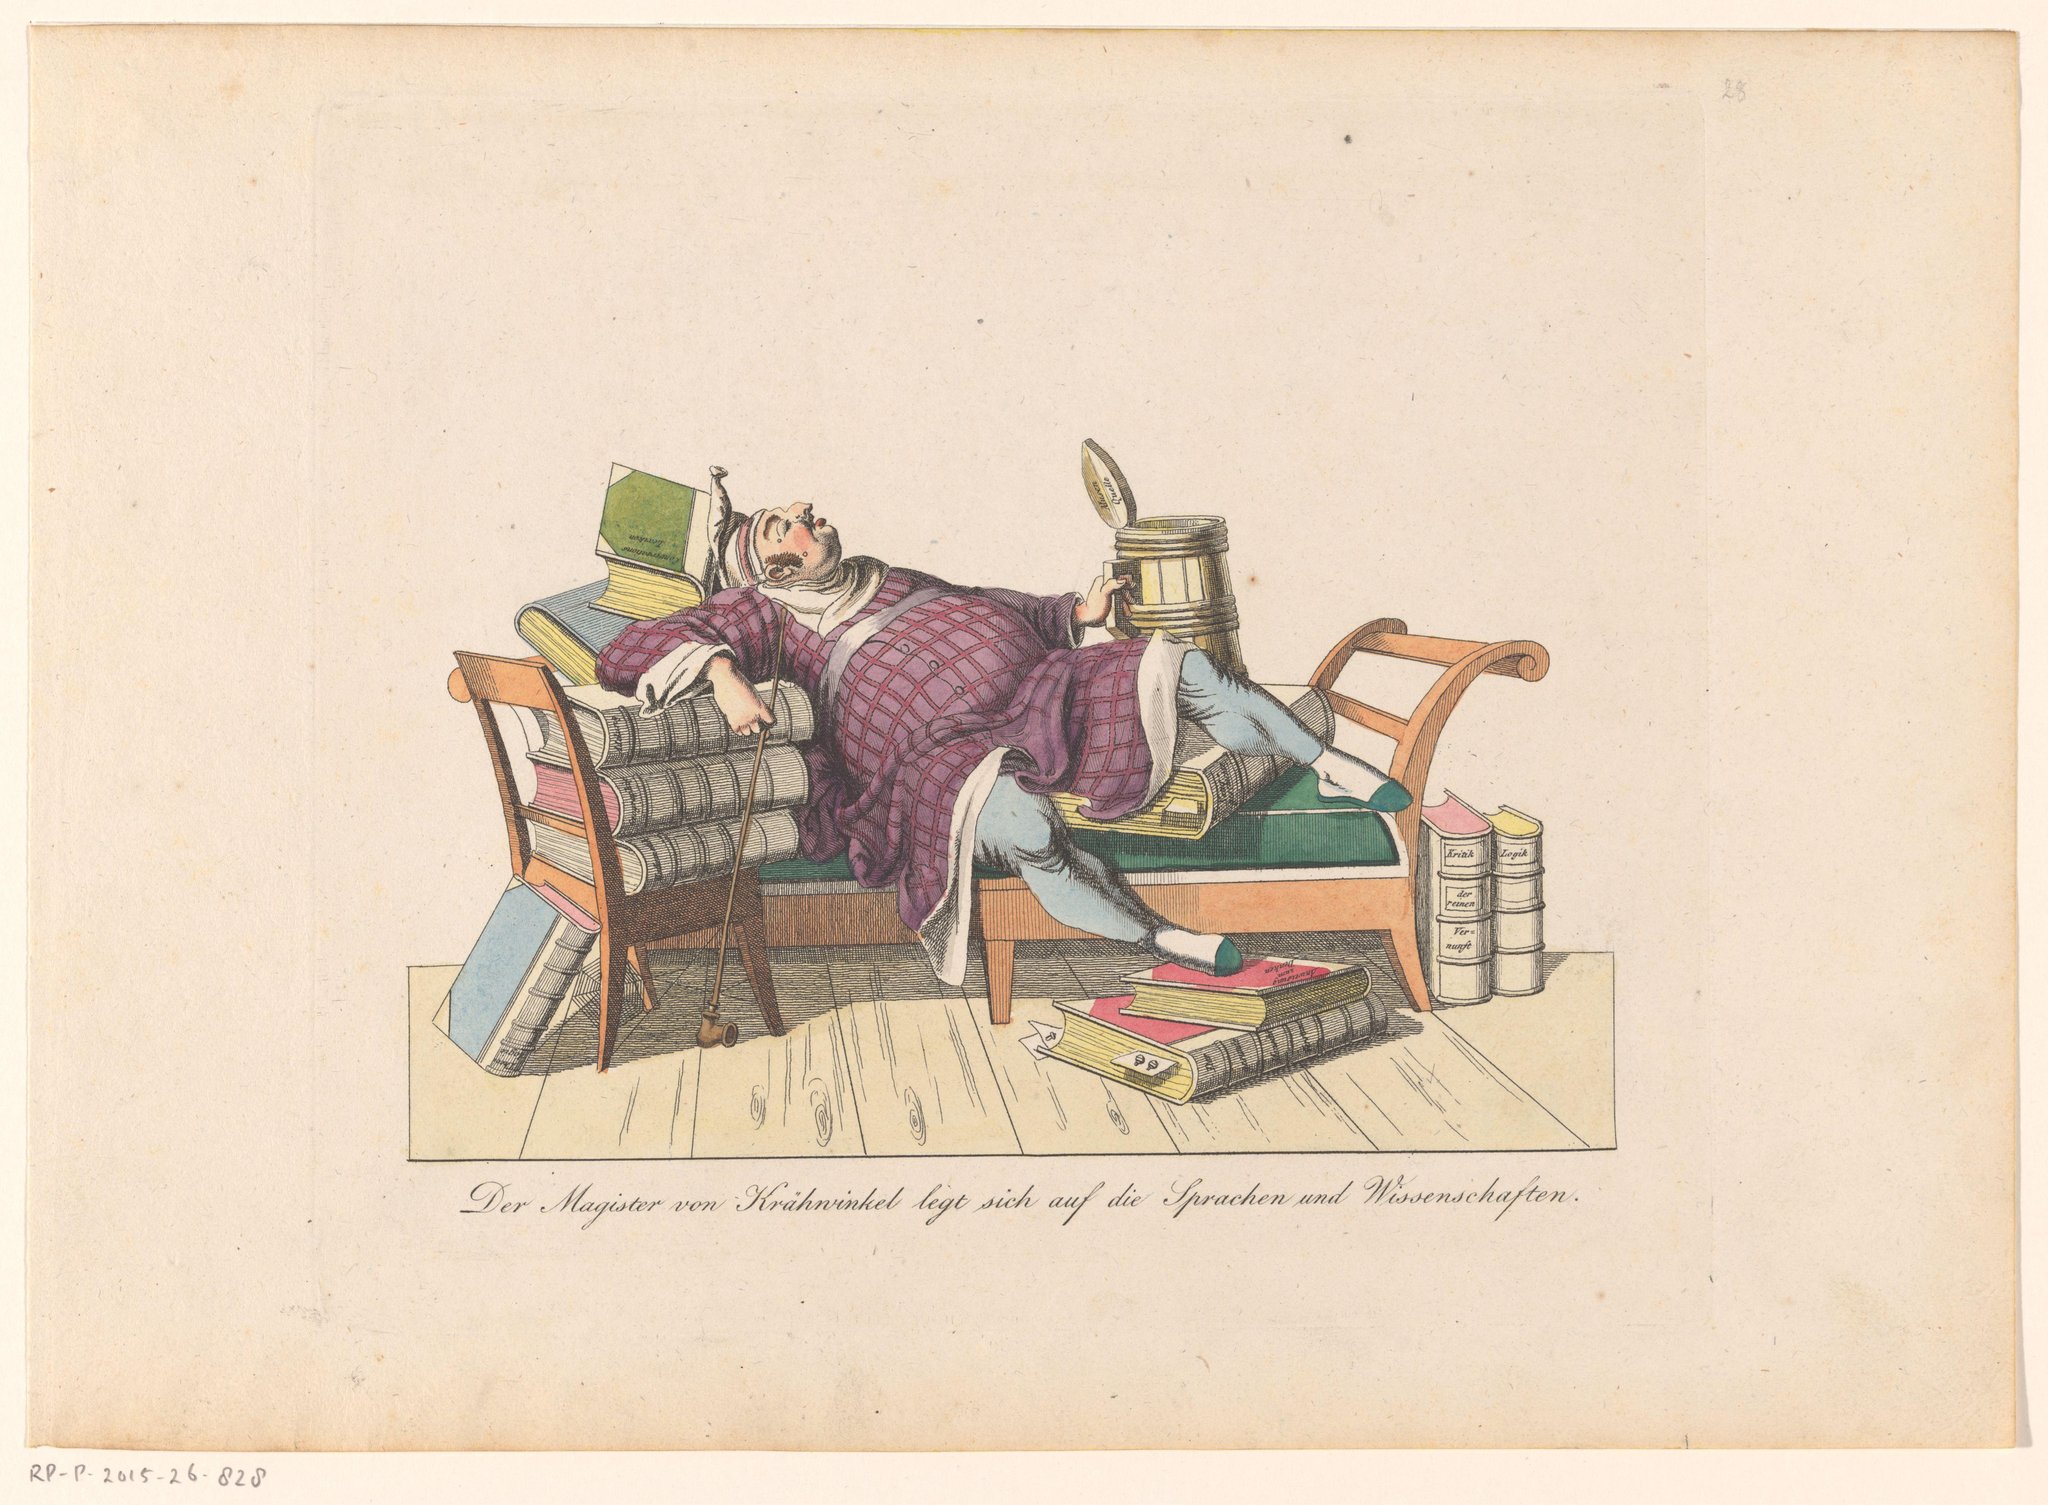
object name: print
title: Der Magister von Krähwinkel legt sich auf die Sprachen und Wissenschaften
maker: johann nussbiegel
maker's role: draughtsman, print maker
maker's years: 1750-1833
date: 1803-1829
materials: paper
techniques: etching, hand coloring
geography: nuremberg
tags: mug, beaker, goblet, pipe ~ tobacco, book, couch, sofa, settee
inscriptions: collector's mark: Lugt 4780, collector's mark: Lugt 4779, collector's mark: Lugt 2228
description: Een dikke man ligt in een ongemakkelijke houding op een sofa, zijn armen en voeten steunend op stapels boeken. In zijn handen houdt hij een pijp en een bierpul. De prent is een letterlijke interpretatie van je "op iets toeleggen".